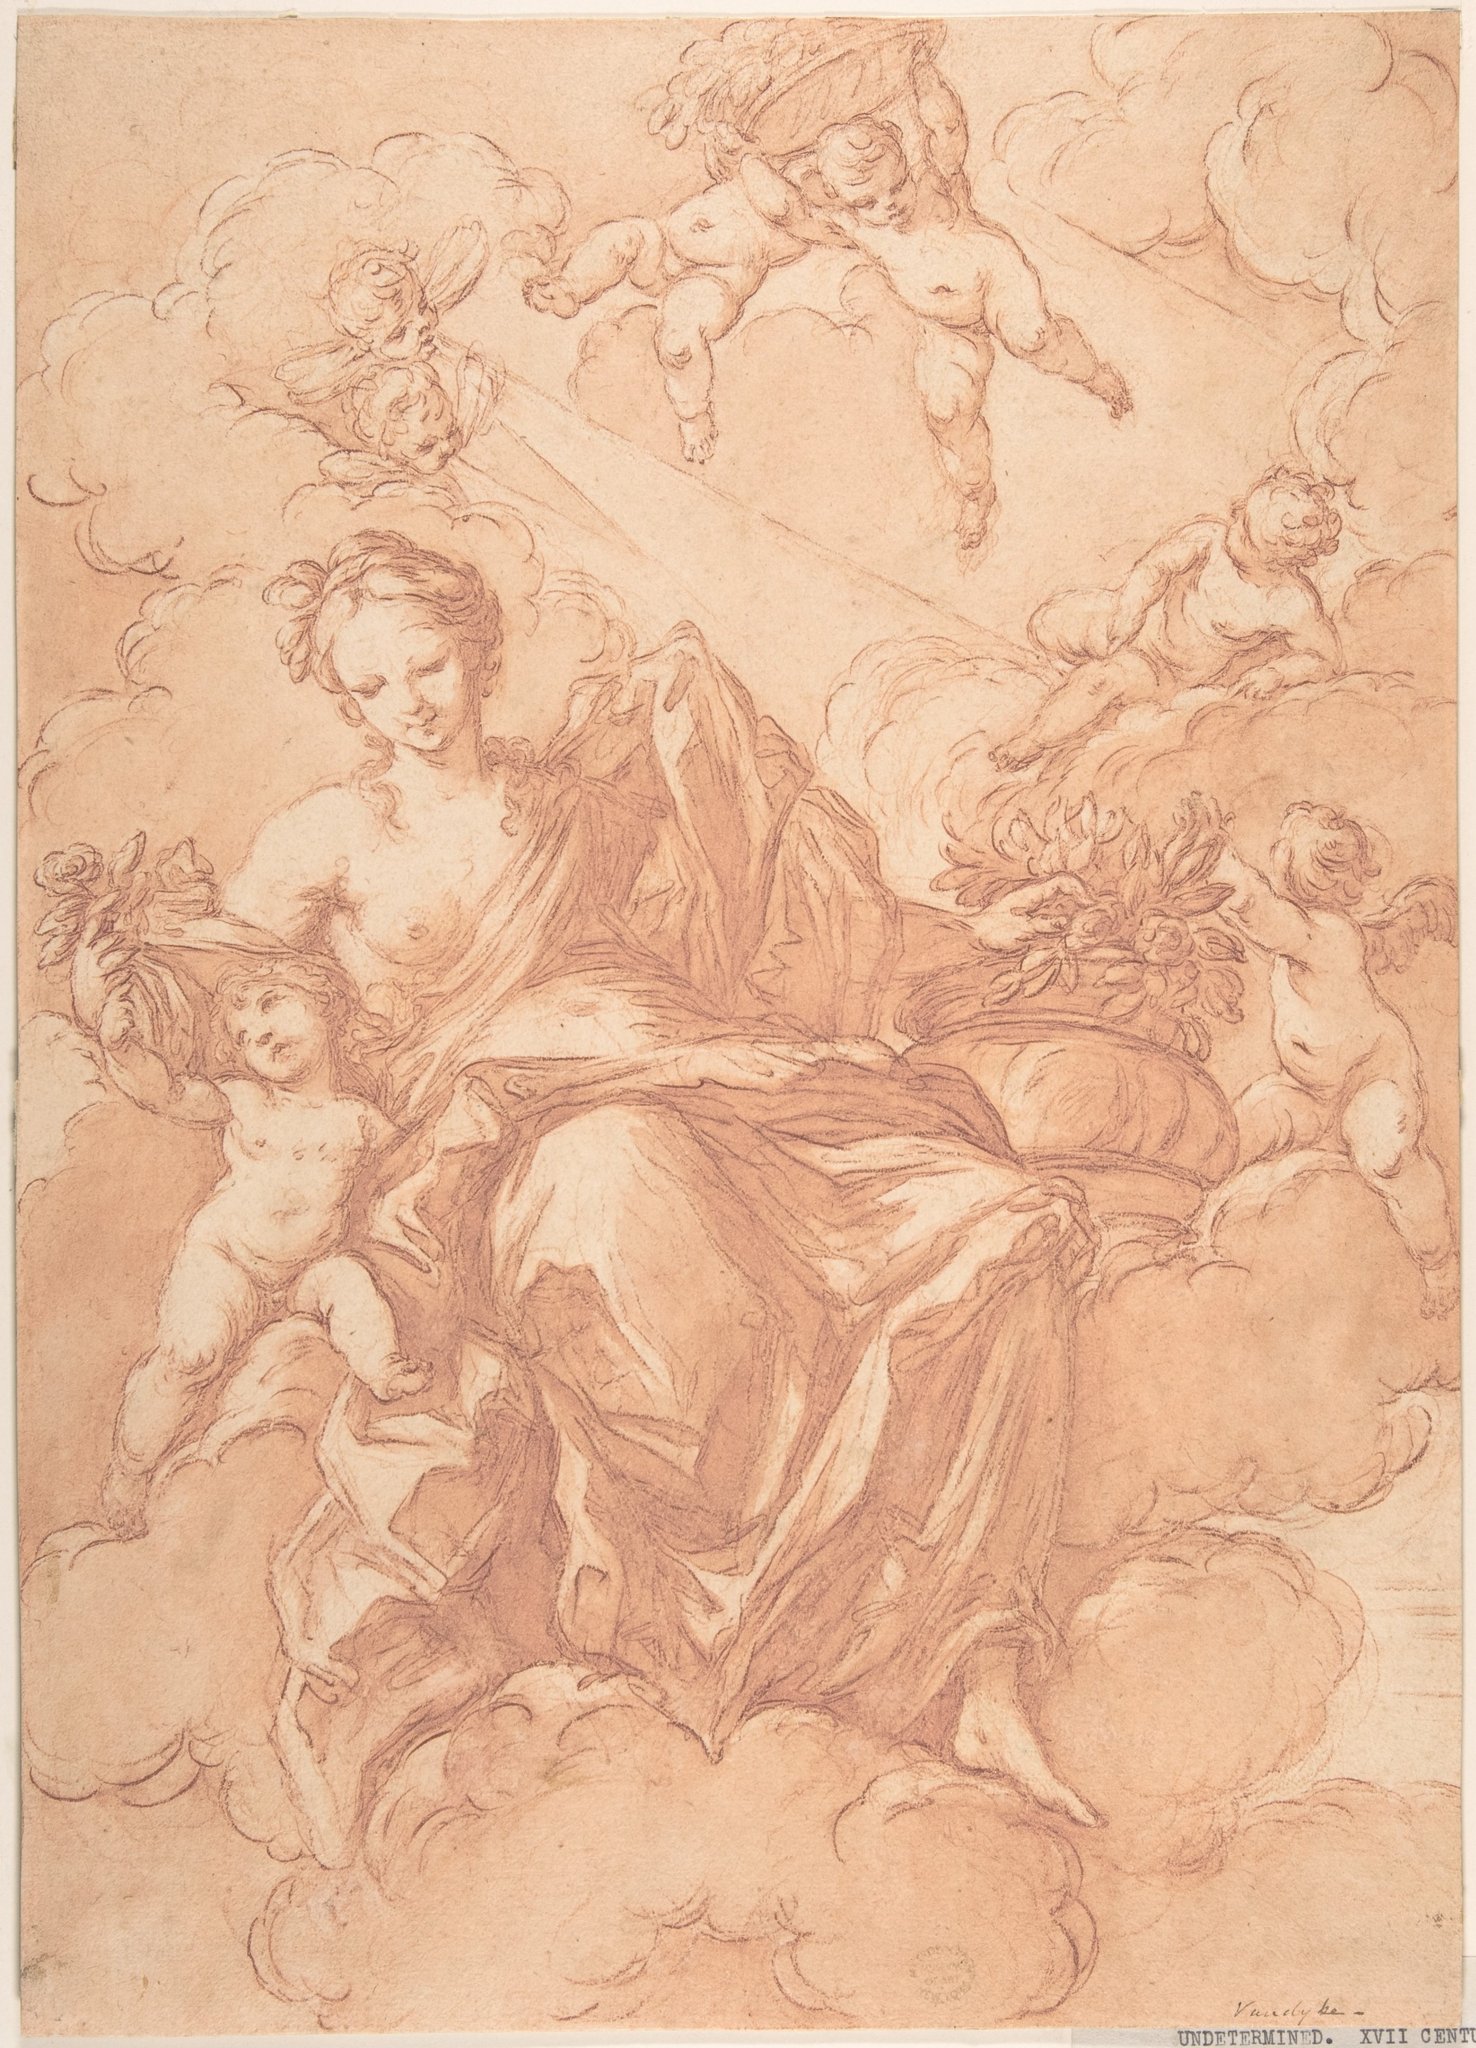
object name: drawing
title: Female Allegorical Figure With Cherubs(?)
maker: anonymous, italian, roman-bolognese, 17th century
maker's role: artist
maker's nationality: italian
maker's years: 1600-1700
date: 1601-1700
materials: chalk, paper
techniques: brush, wash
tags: women,angels